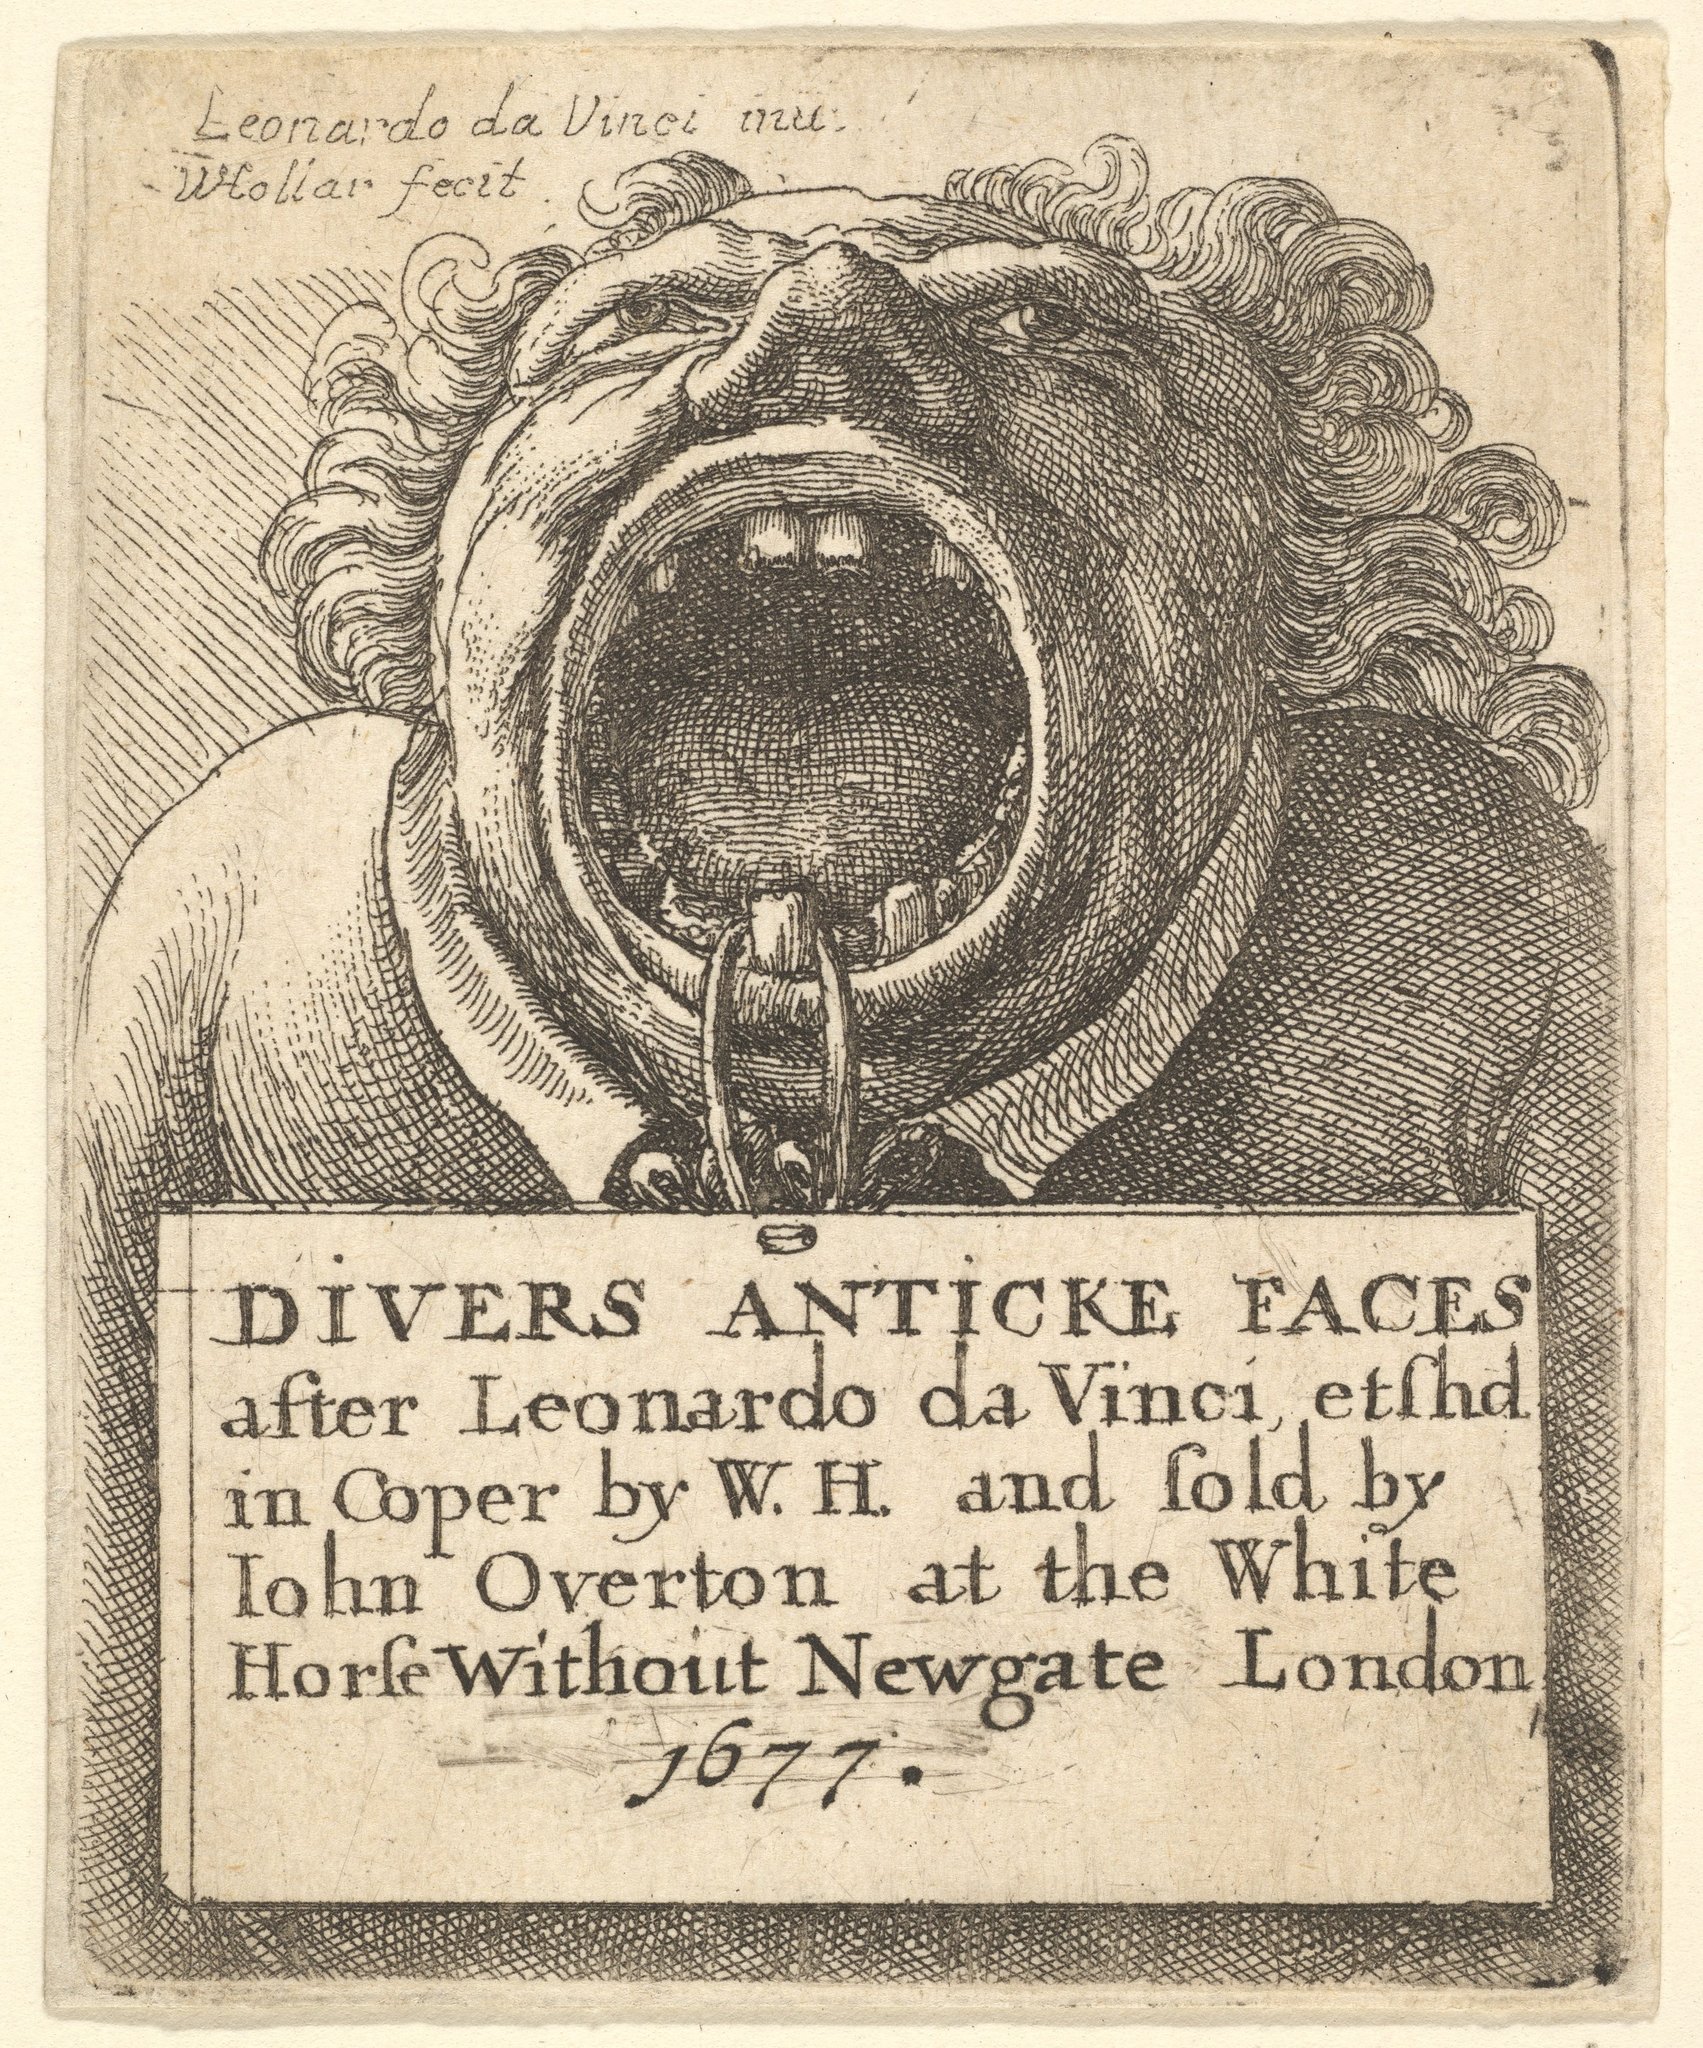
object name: print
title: Title Page, Divers Anticke Faces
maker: wenceslaus hollar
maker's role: artist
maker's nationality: bohemian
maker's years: 1607-1677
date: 1677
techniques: etching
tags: mouths,men